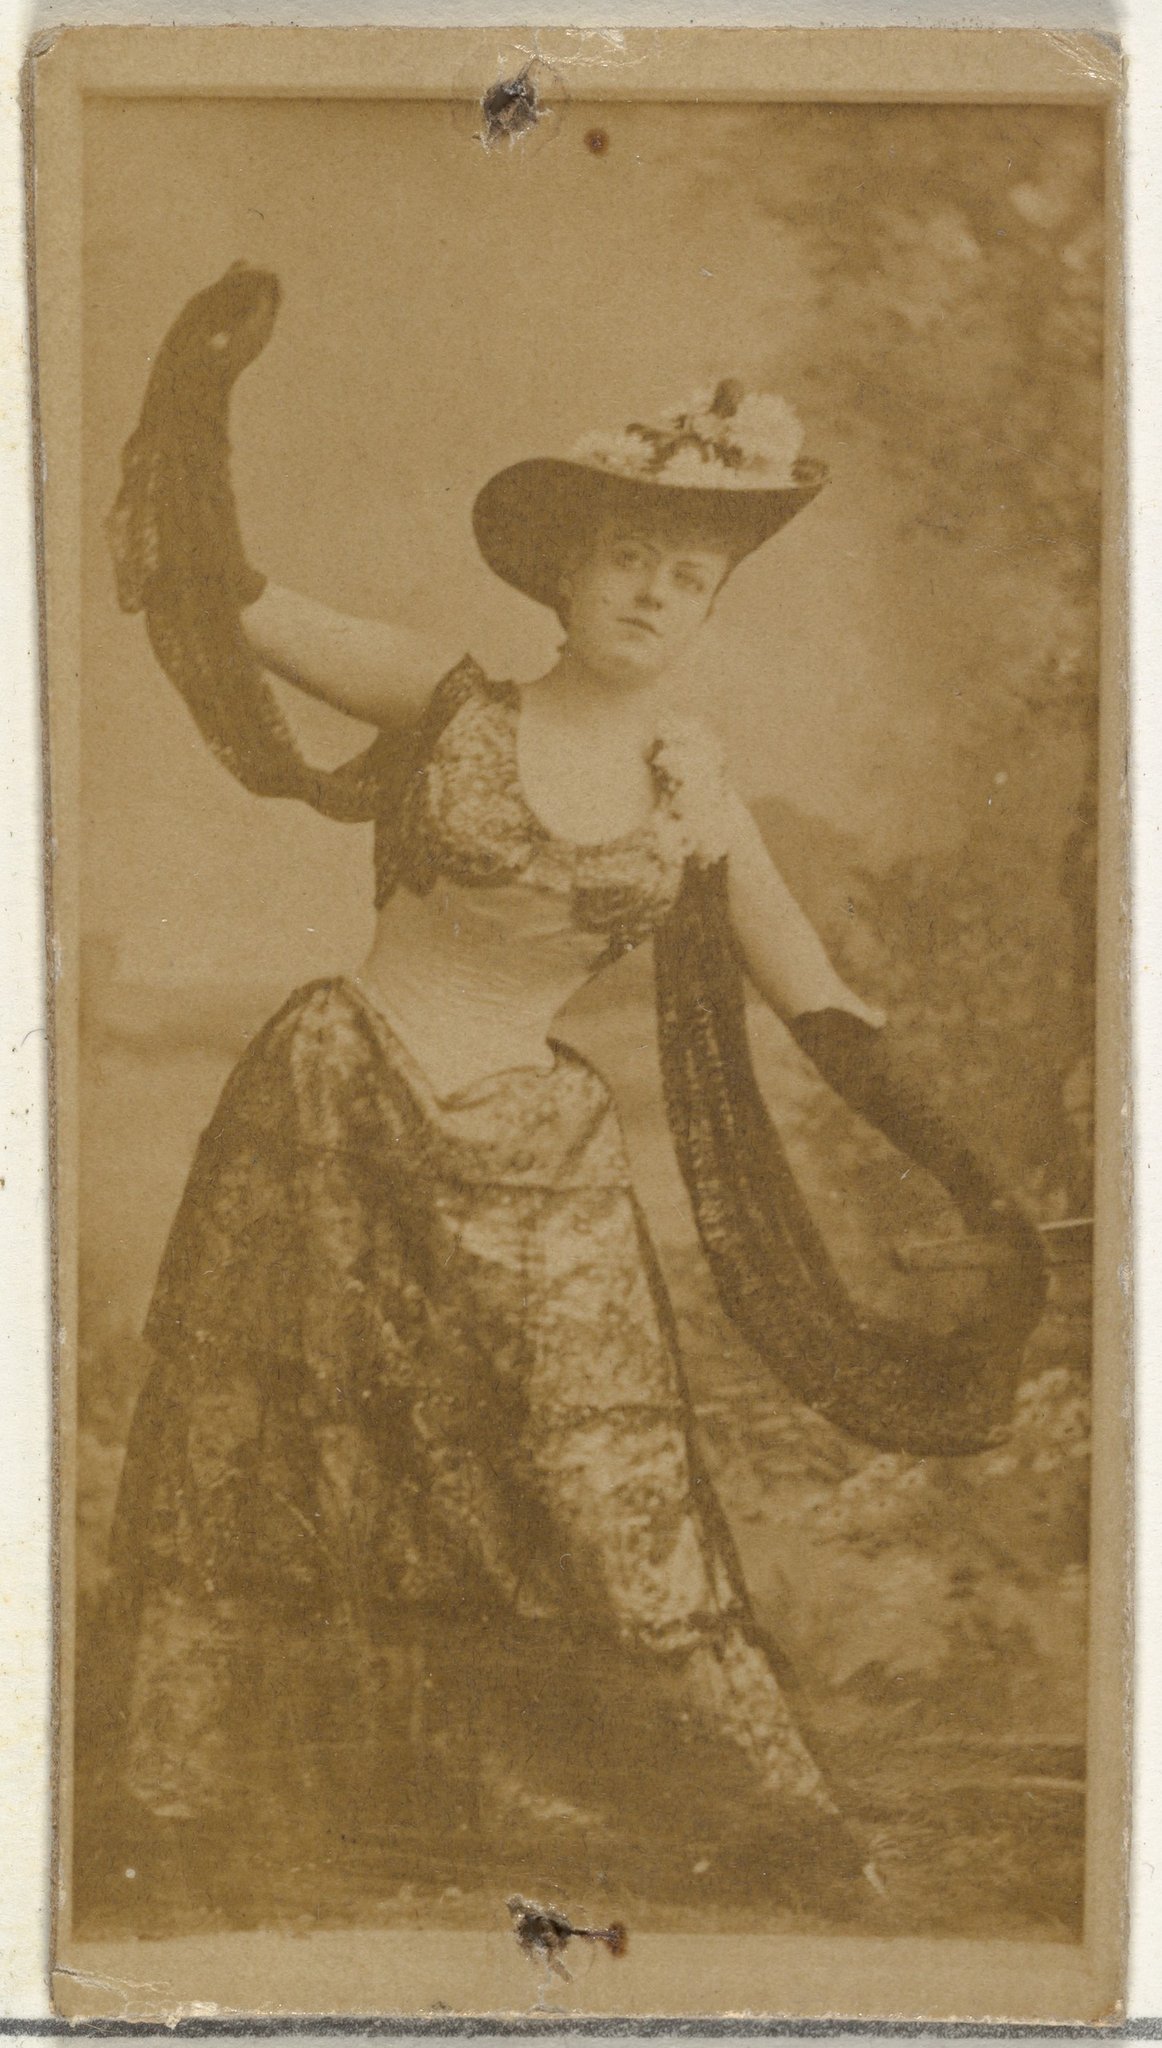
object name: photograph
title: [Actress in full-length shows off ornate gown], from the Actors and Actresses series (N145-8) issued by Duke Sons & Co. to promote Duke Cigarettes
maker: w. duke, sons & co.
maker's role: publisher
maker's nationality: american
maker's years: 1870-1920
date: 1891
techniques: albumen silver print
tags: portraits,women,actresses